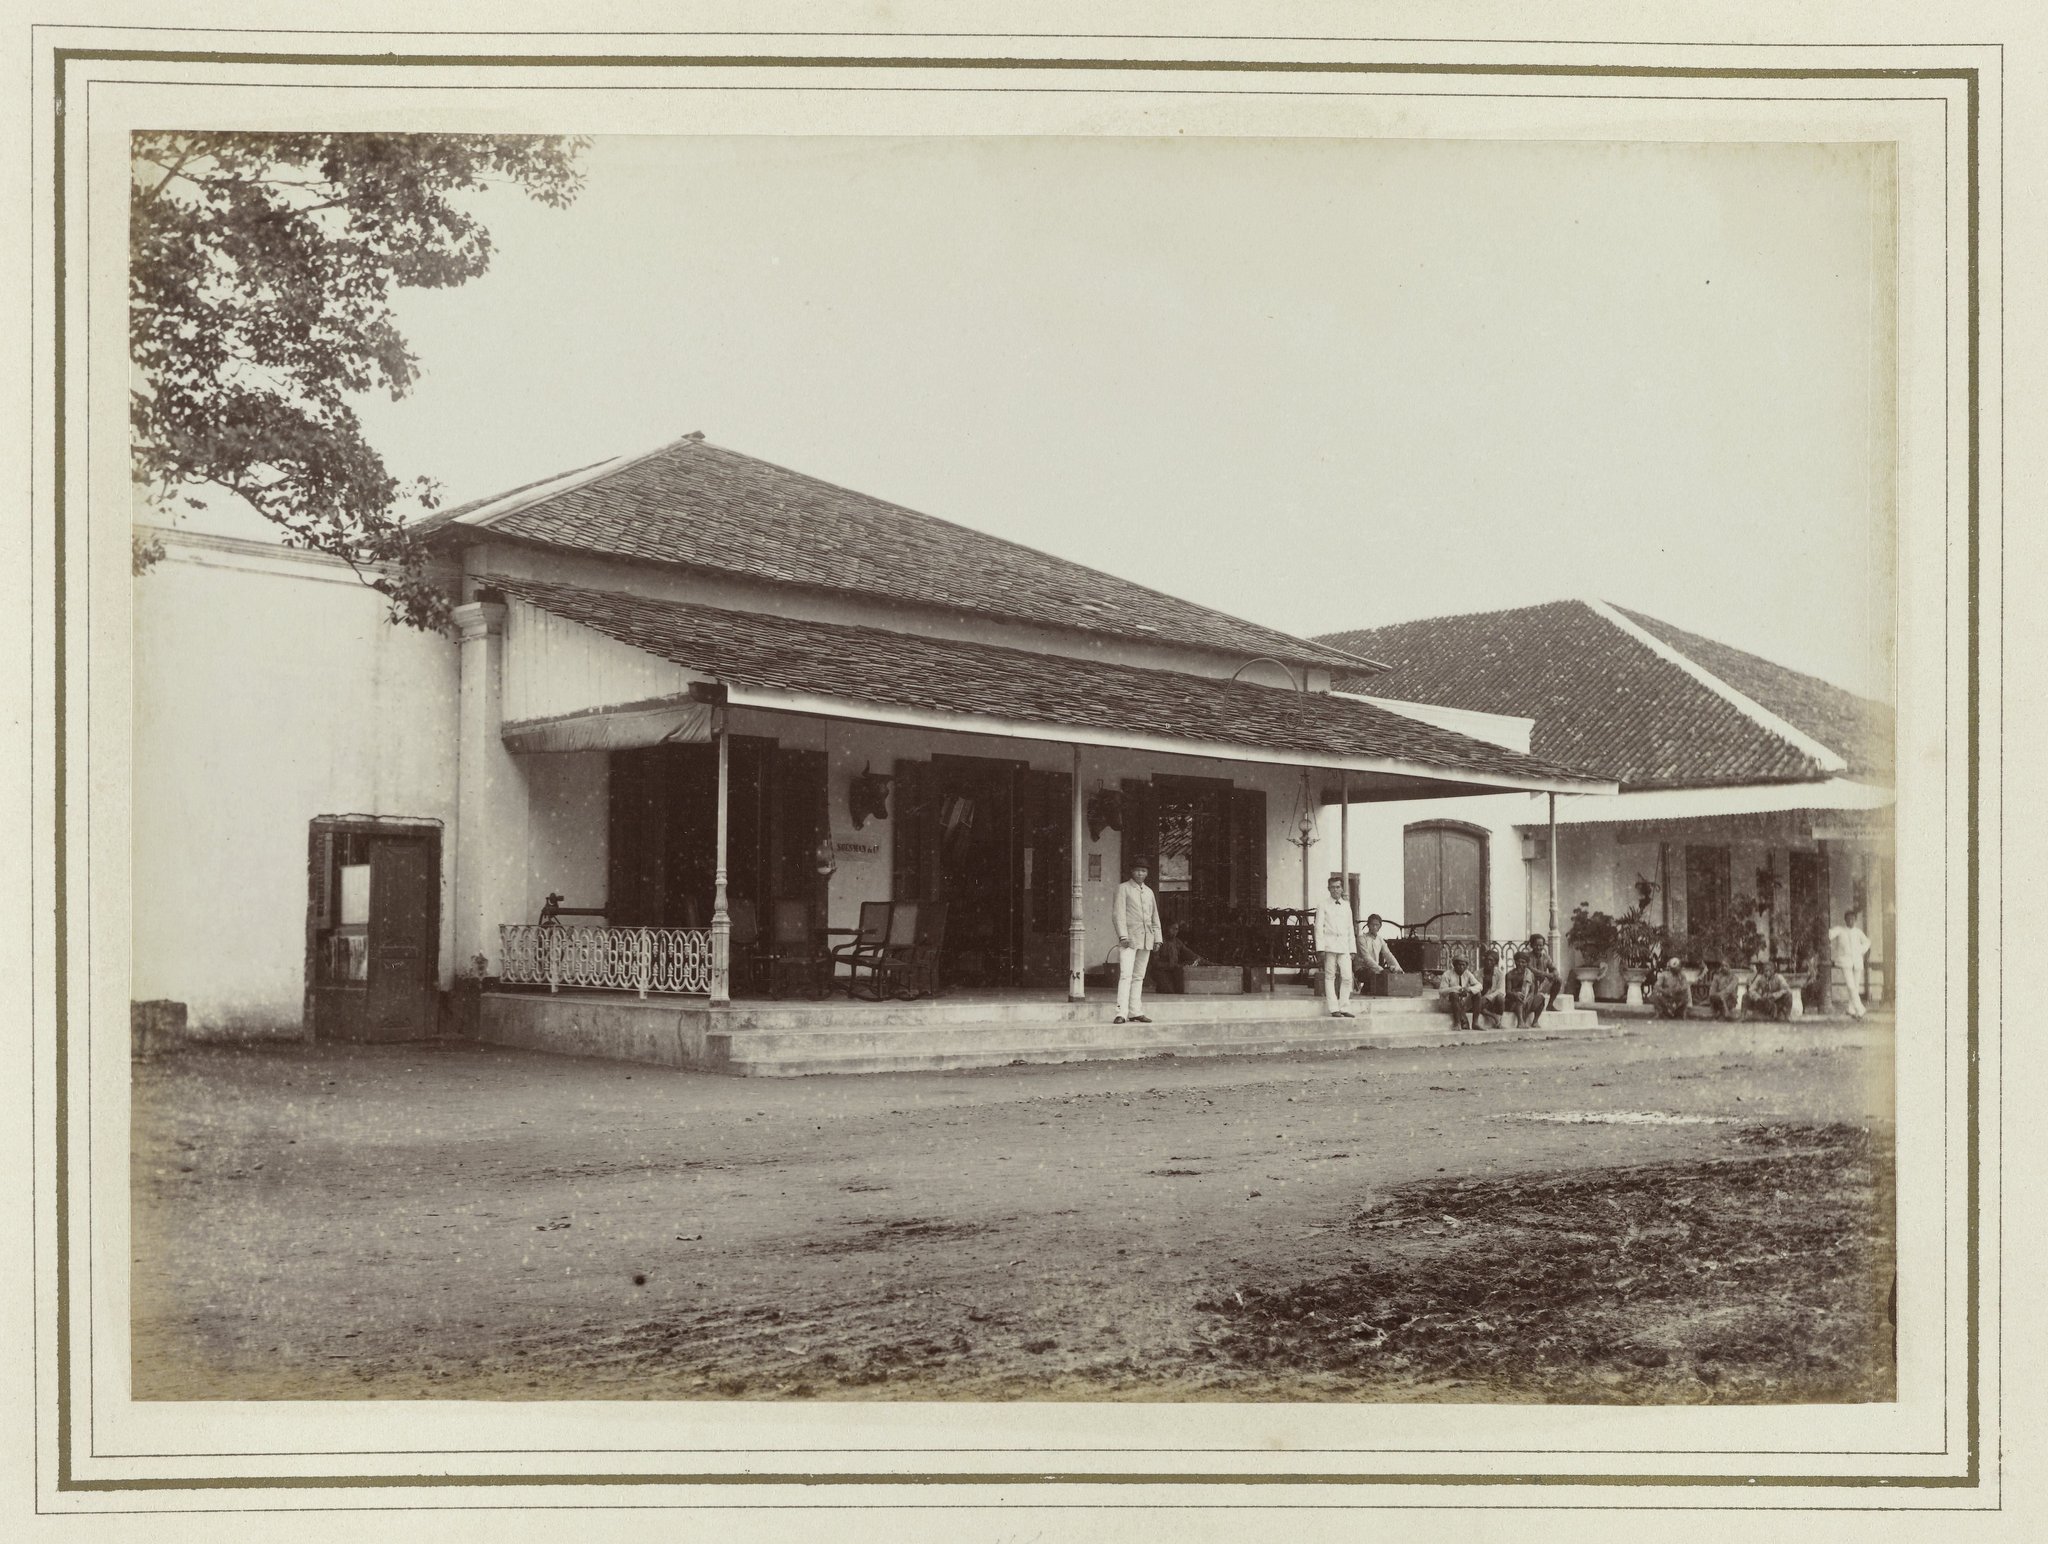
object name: photograph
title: Pand van Soesman & Co.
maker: kassian céphas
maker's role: fotograaf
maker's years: 1845-1912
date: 1886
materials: photographic support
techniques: albumen print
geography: jogjakarta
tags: the hague, edifice, e.g.: public building, department store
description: Het gebouw van het bedrijf Soesman & Co., gelegen naast het Agentschap der Javasche Bank aan een straat in Jogyakarta. Onderdeel van het fotoalbum aangeboden aan J.M. Pijnacker Hordijk bij zijn vertrek uit Jogyakarta in 1886.